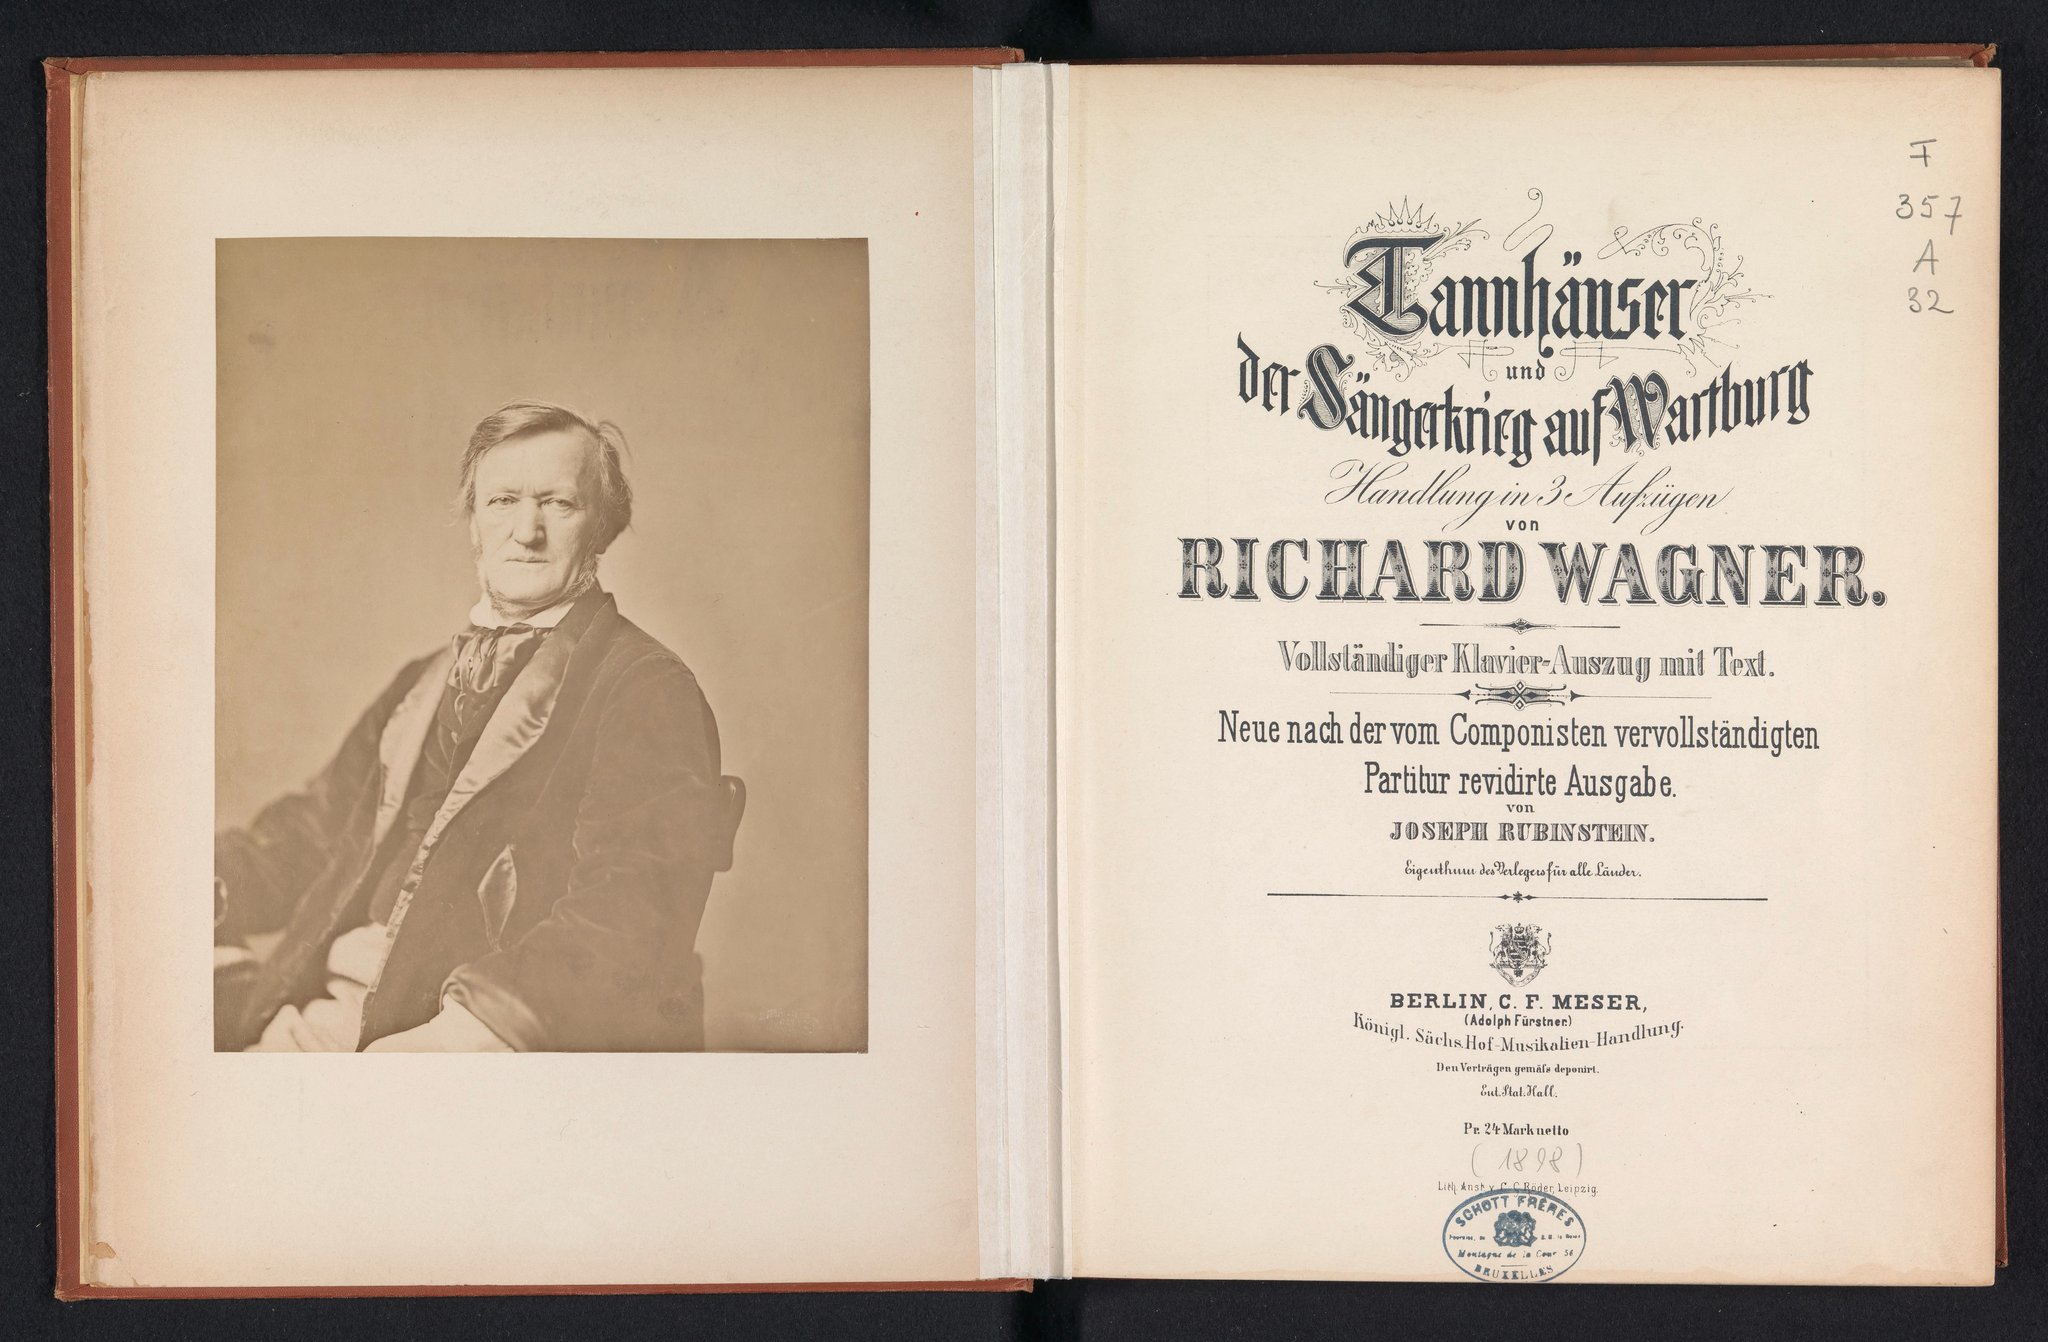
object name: book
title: Tannhäuser und der Sängerkrieg auf Wartburg Handlung in 3 Aufzügen vopllsträndiger Klavier-Auszug mit Text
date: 1898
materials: cardboard, linen, paper, photographic support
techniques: albumen print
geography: berlin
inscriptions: name: ‘Schott Freres [...] Bruxelles’